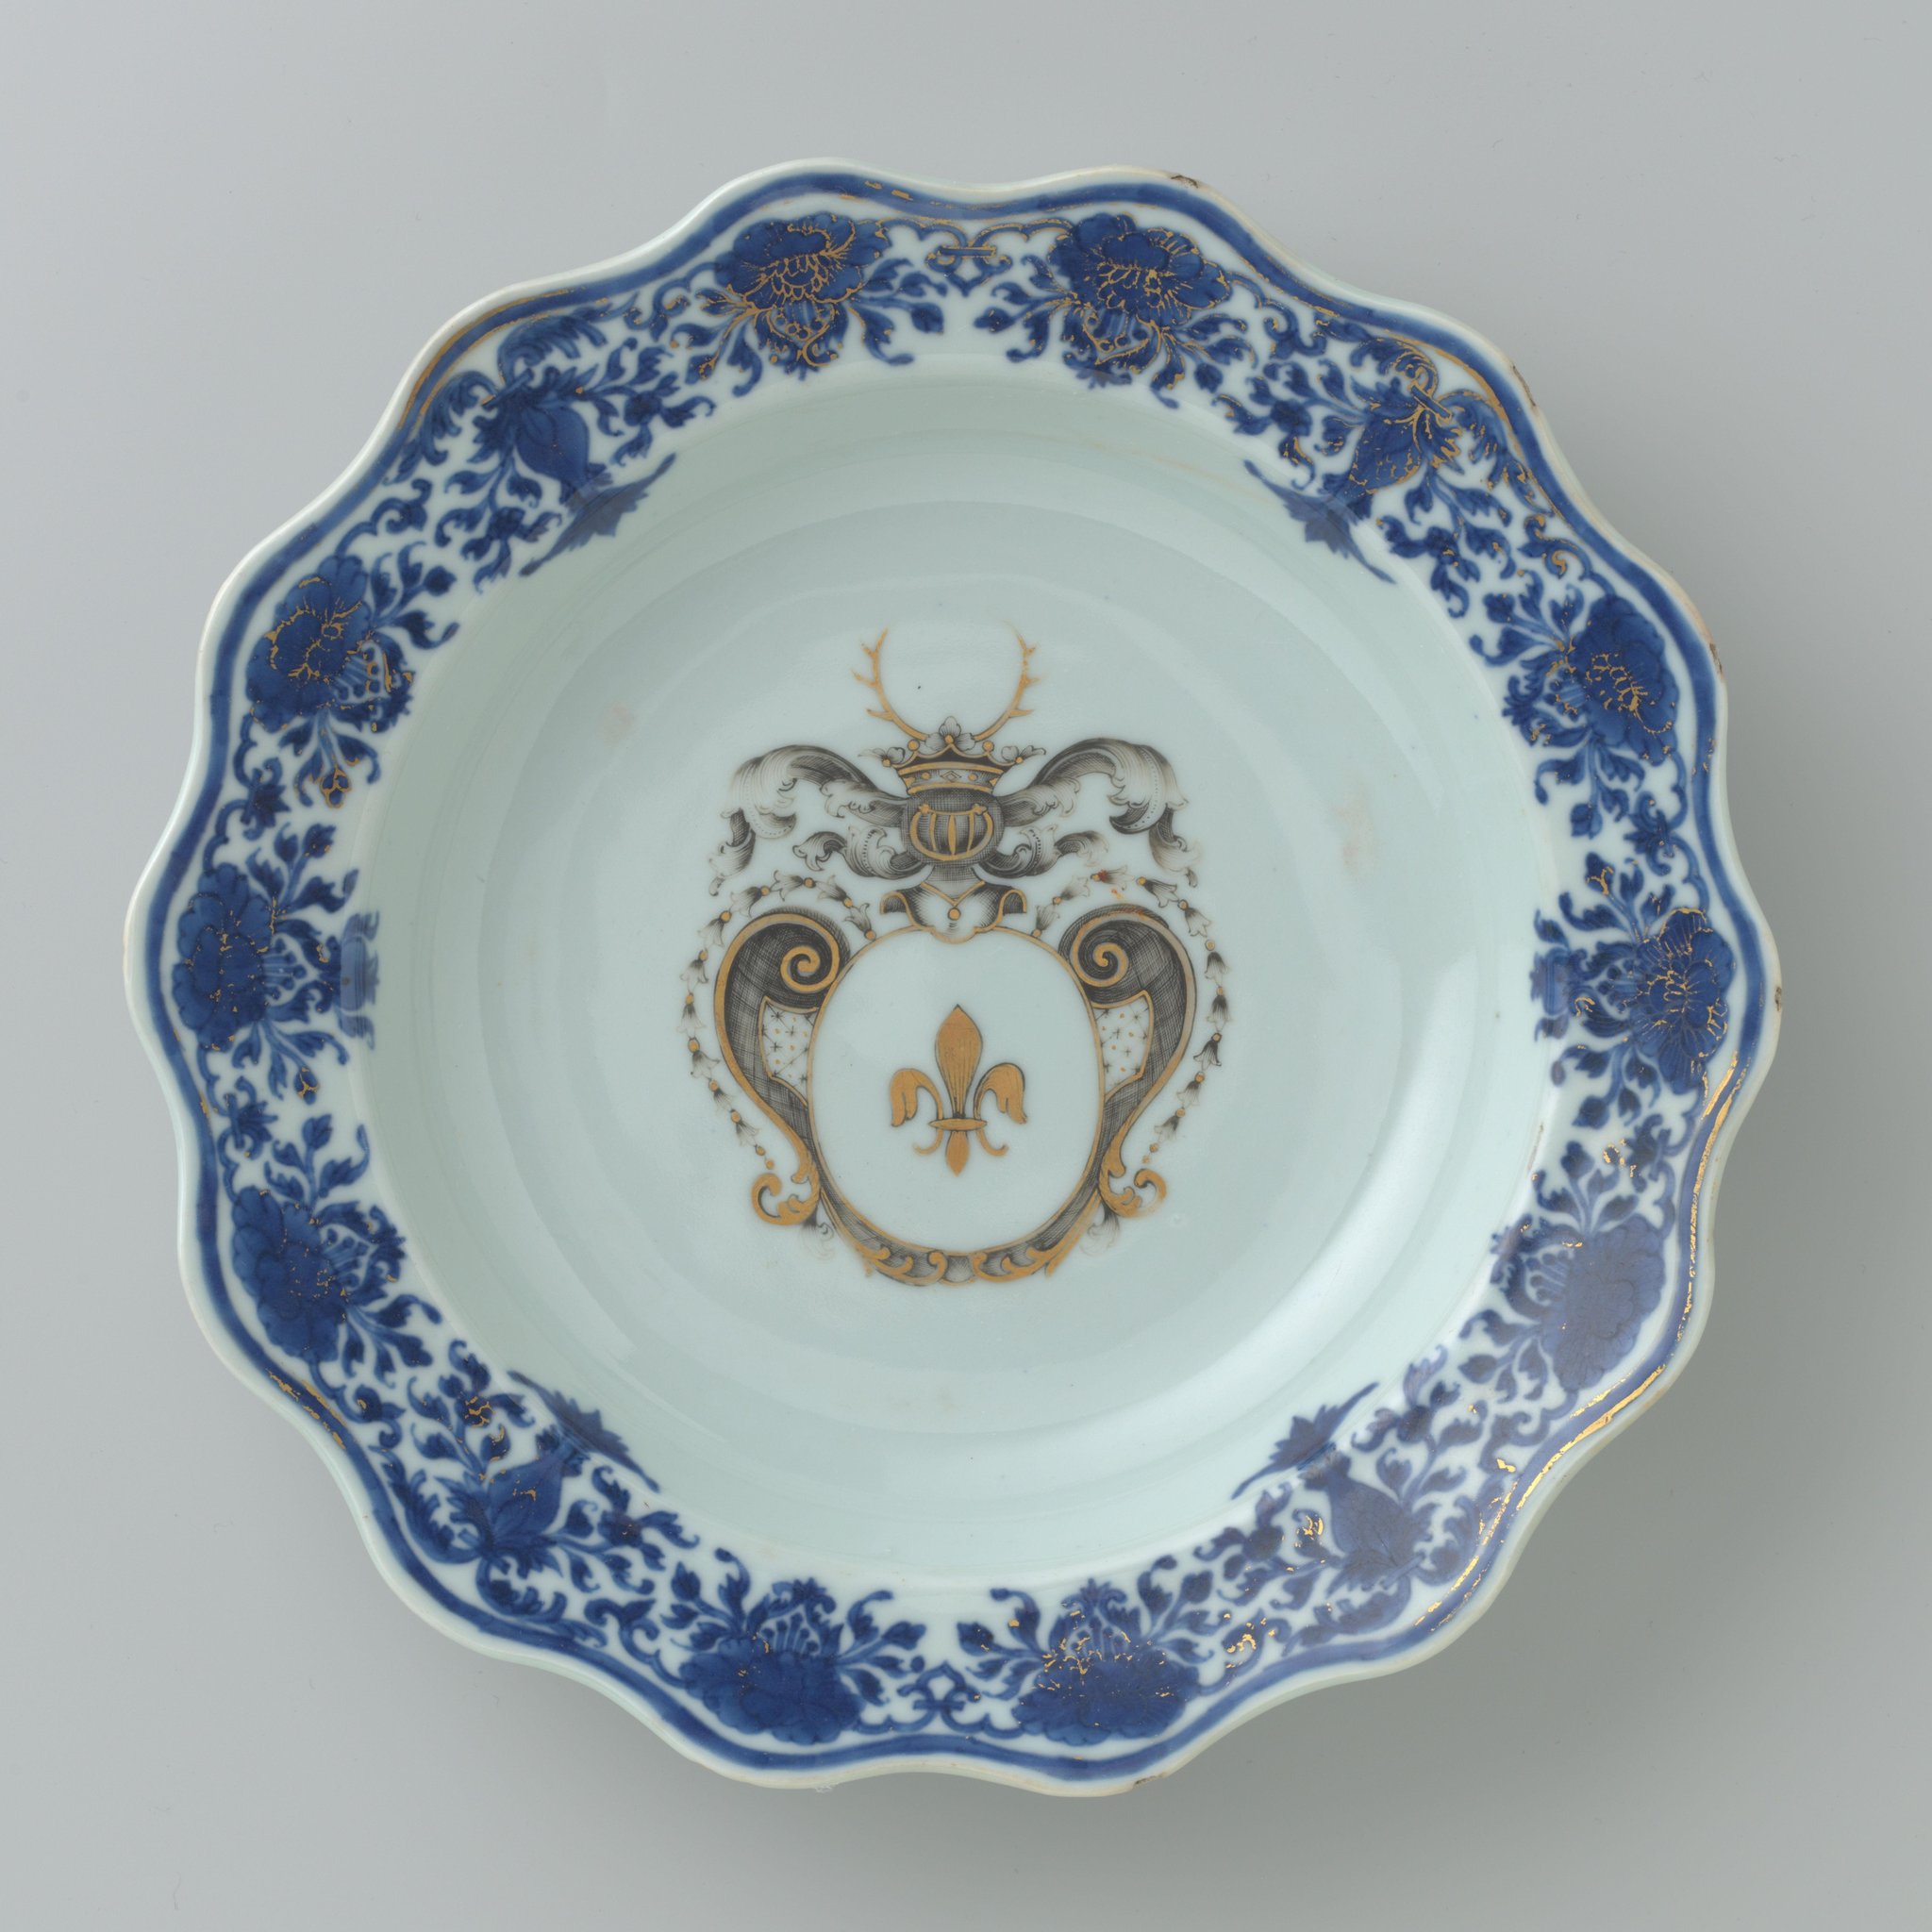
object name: soup plate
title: Soepbord met het wapen van de familie Swellengrebel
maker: Anonymous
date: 1740-1750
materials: cobalt, glaze, gold, paint, porcelain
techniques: firing, gilding, turning, vitrification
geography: china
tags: gouverneur, hendrik swellengrebel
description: Soepbord op een standring en met een golvende rand. Beschilderd in onderglazuur blauw en met zwart en goud op het glazuur. Rond de rand een brede band met bandwerk en bloemranken in blauw met goud. In het centrum het wapen van de familie Swellengrebel in zwart en goud: Franse lelie op een ovaal schild en een gewei boven een kroon als helmteken. Wapenporselein in blauw-wit en emailkleuren.